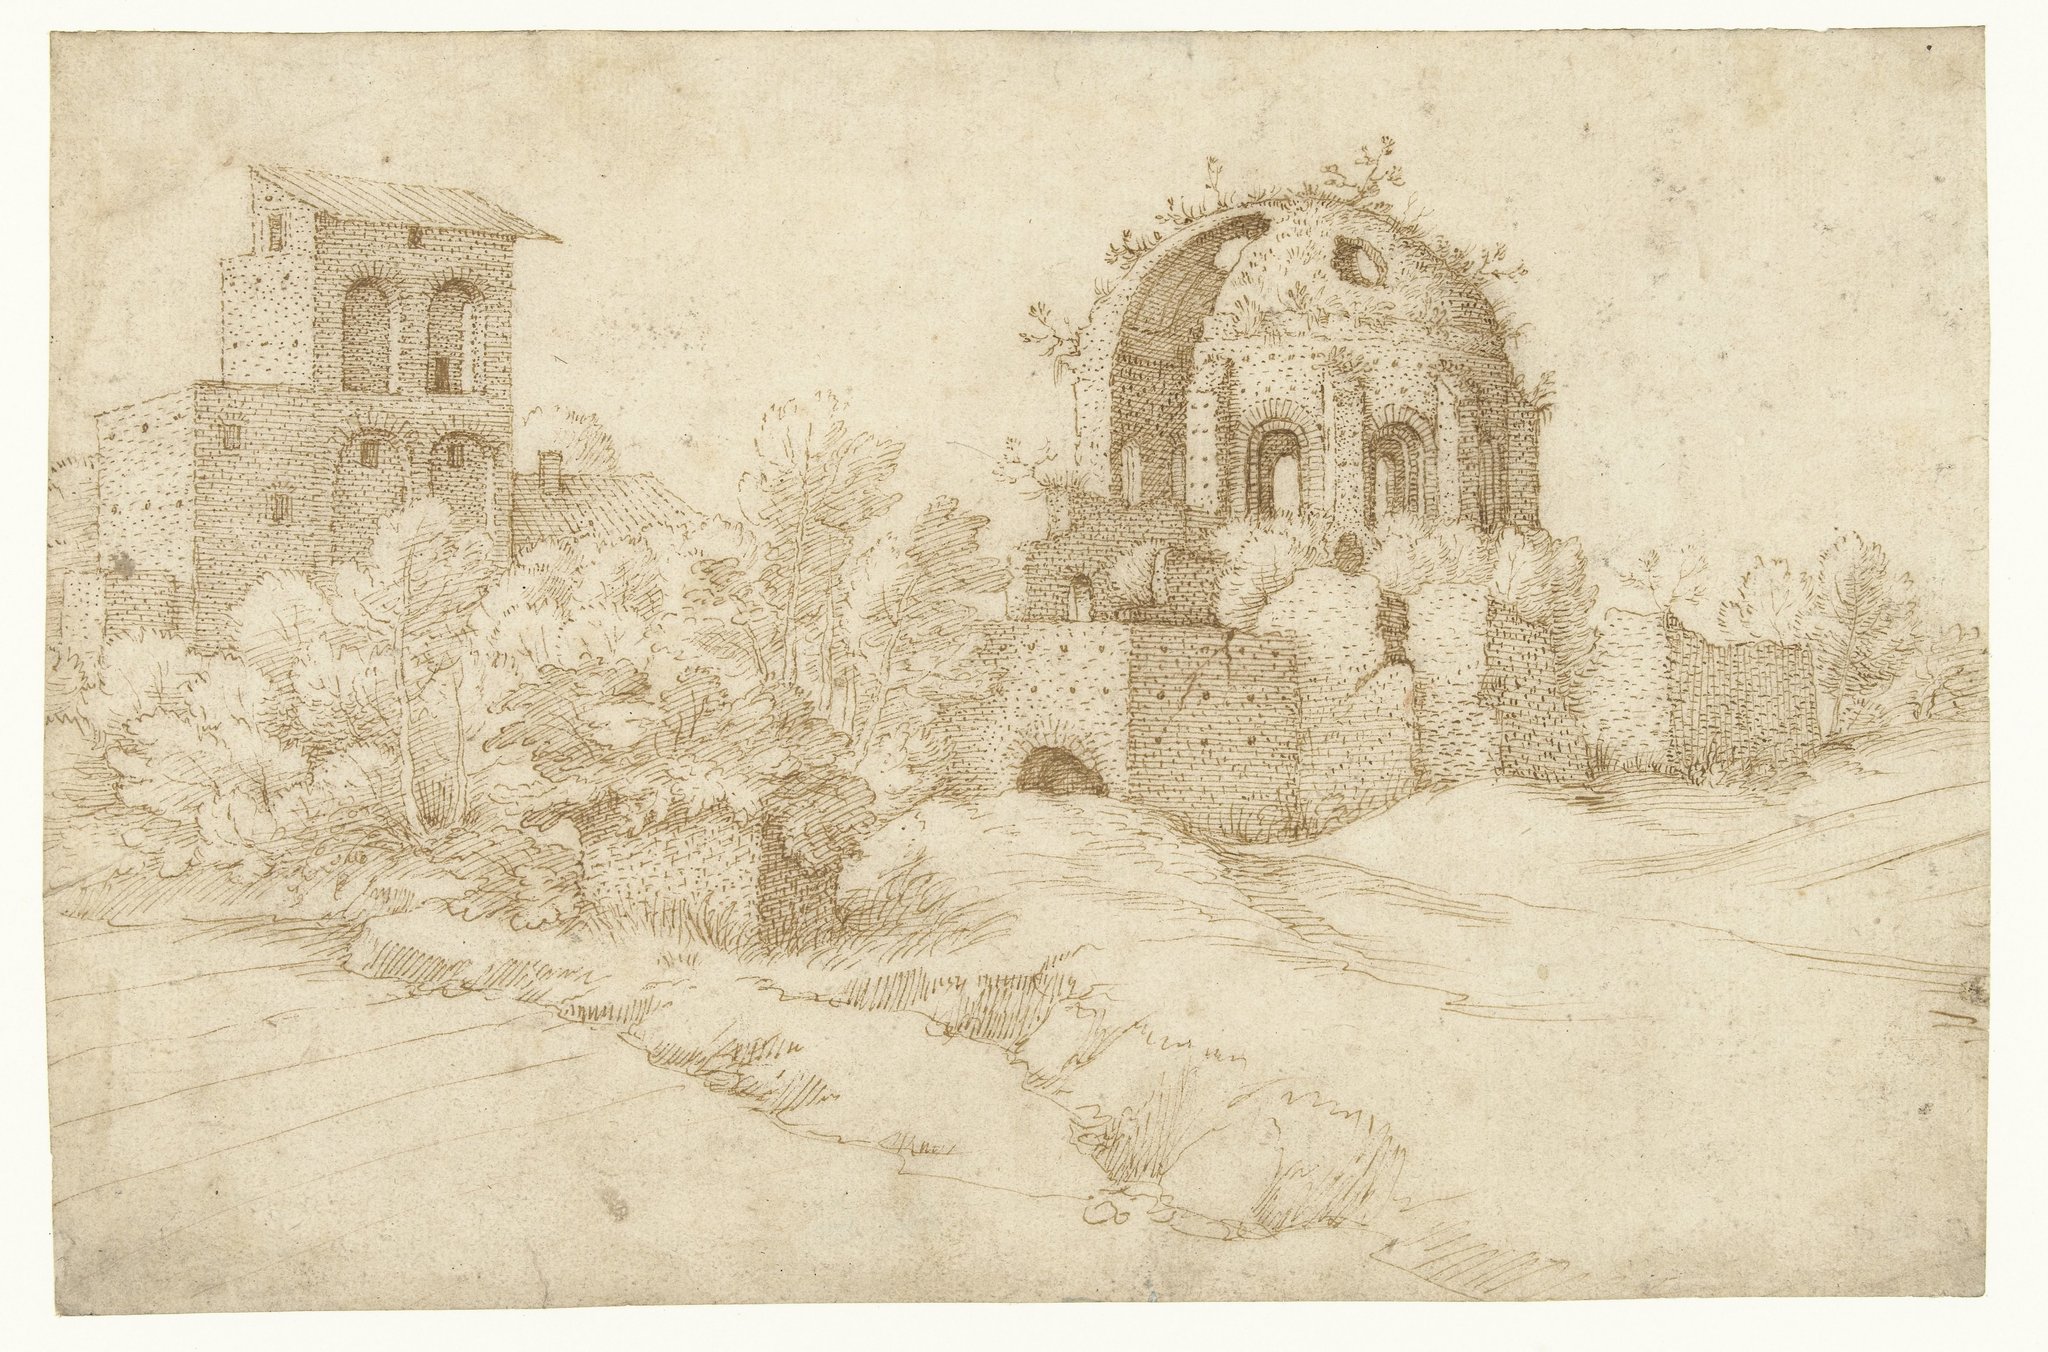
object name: drawing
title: Gezicht op de tempel van Minerva Medica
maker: jacques franckaert (i)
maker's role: draughtsman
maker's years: 1550-1601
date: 1585-1601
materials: ink, paper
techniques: pen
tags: (story of) minerva (pallas, athena)